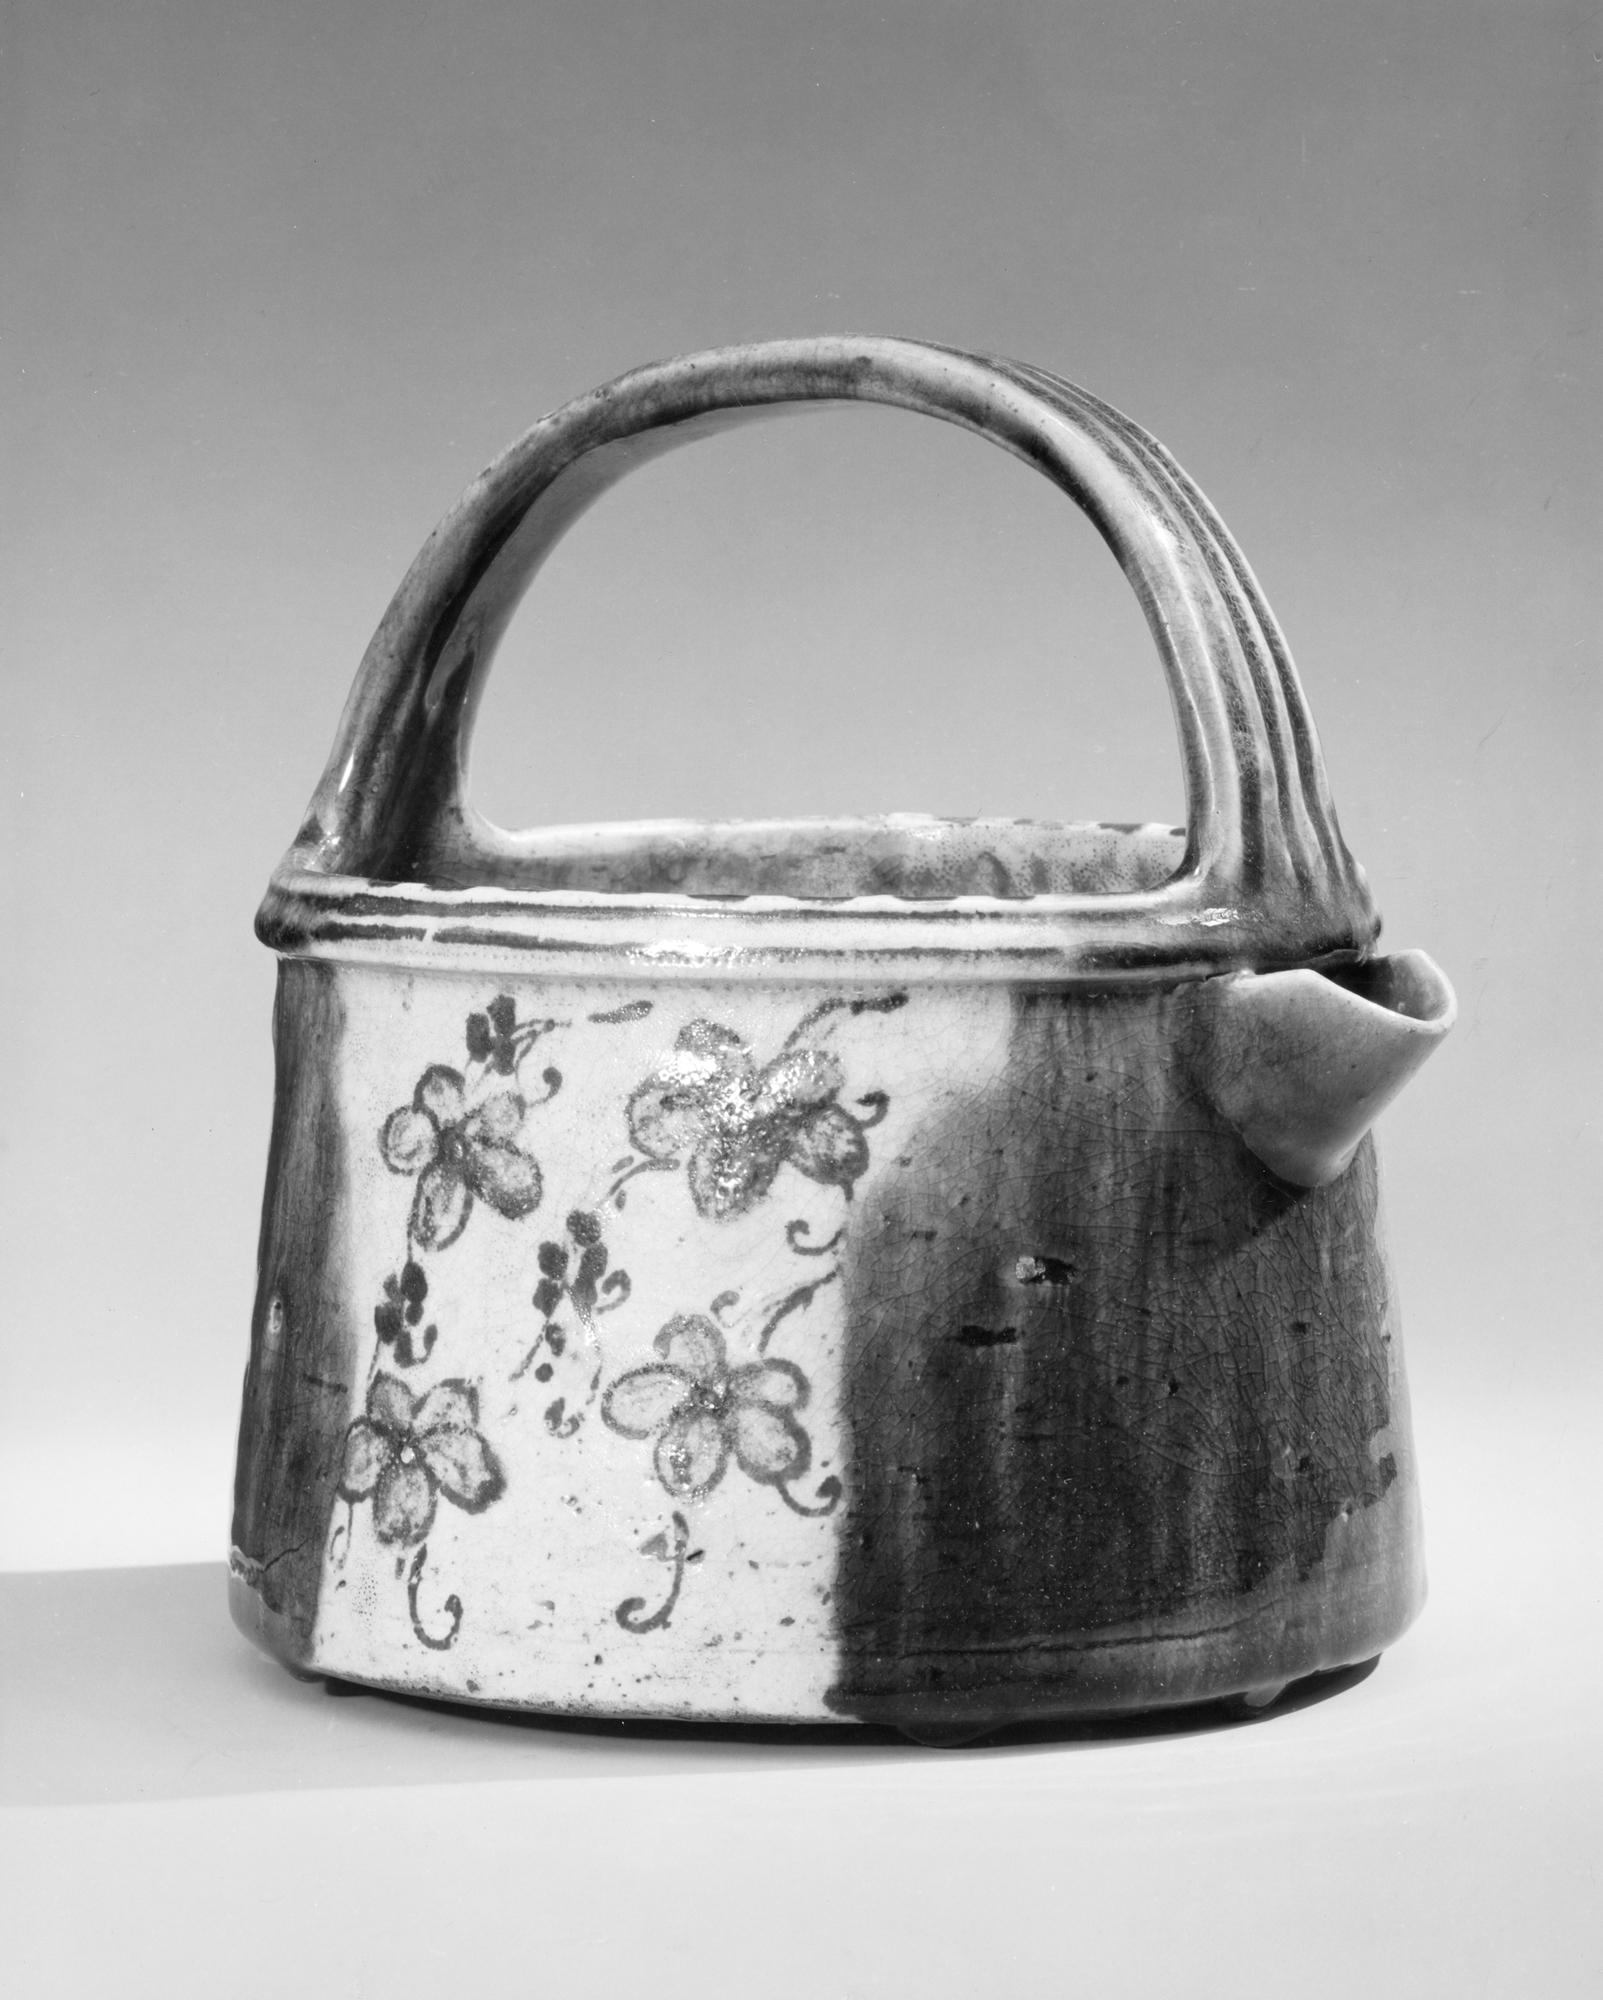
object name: ewer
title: Ewer in the Shape of a Bucket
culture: japanese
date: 1801-1833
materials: stoneware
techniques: glazing